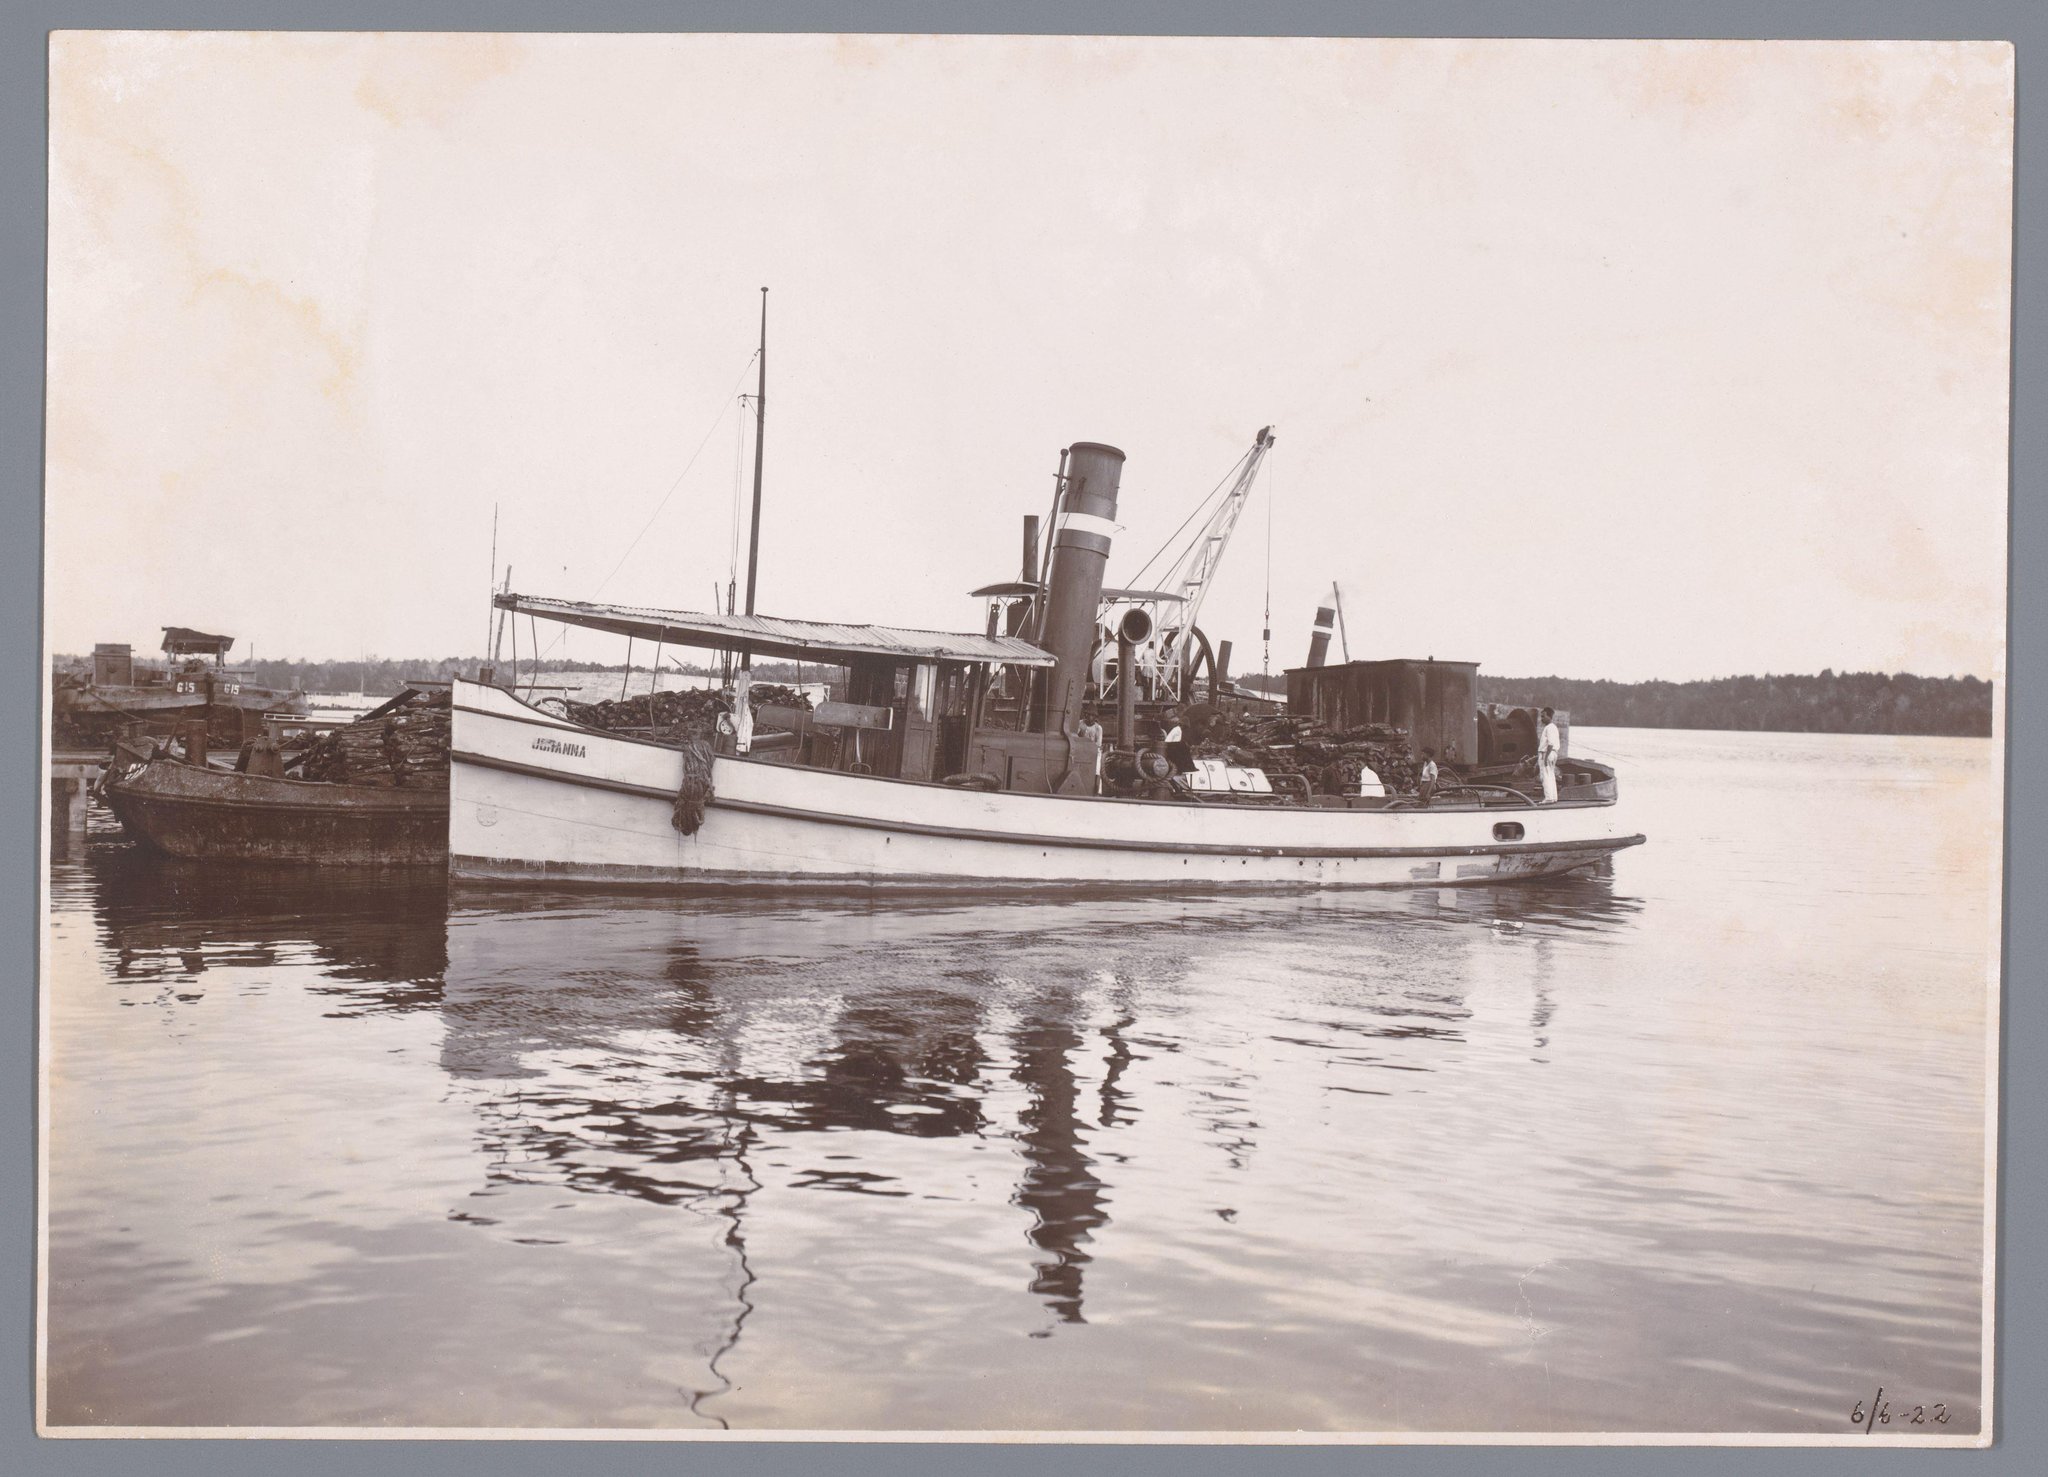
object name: photograph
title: Sleepboot "Johanna"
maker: Anonymous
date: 1922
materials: photographic support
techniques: gelatin silver print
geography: belawan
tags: harbour, building-site, tug, pusher tug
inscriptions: inscription: ‘No 166 Sleepboot "Johanna"’, date: ‘6/6-22’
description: De sleepboot "Johanna". Genummerd: 166. Onderdeel van de groep van losse foto's over de aanleg van de haven Belawan aan de kust voor Medan, Sumatra 1921-1922.